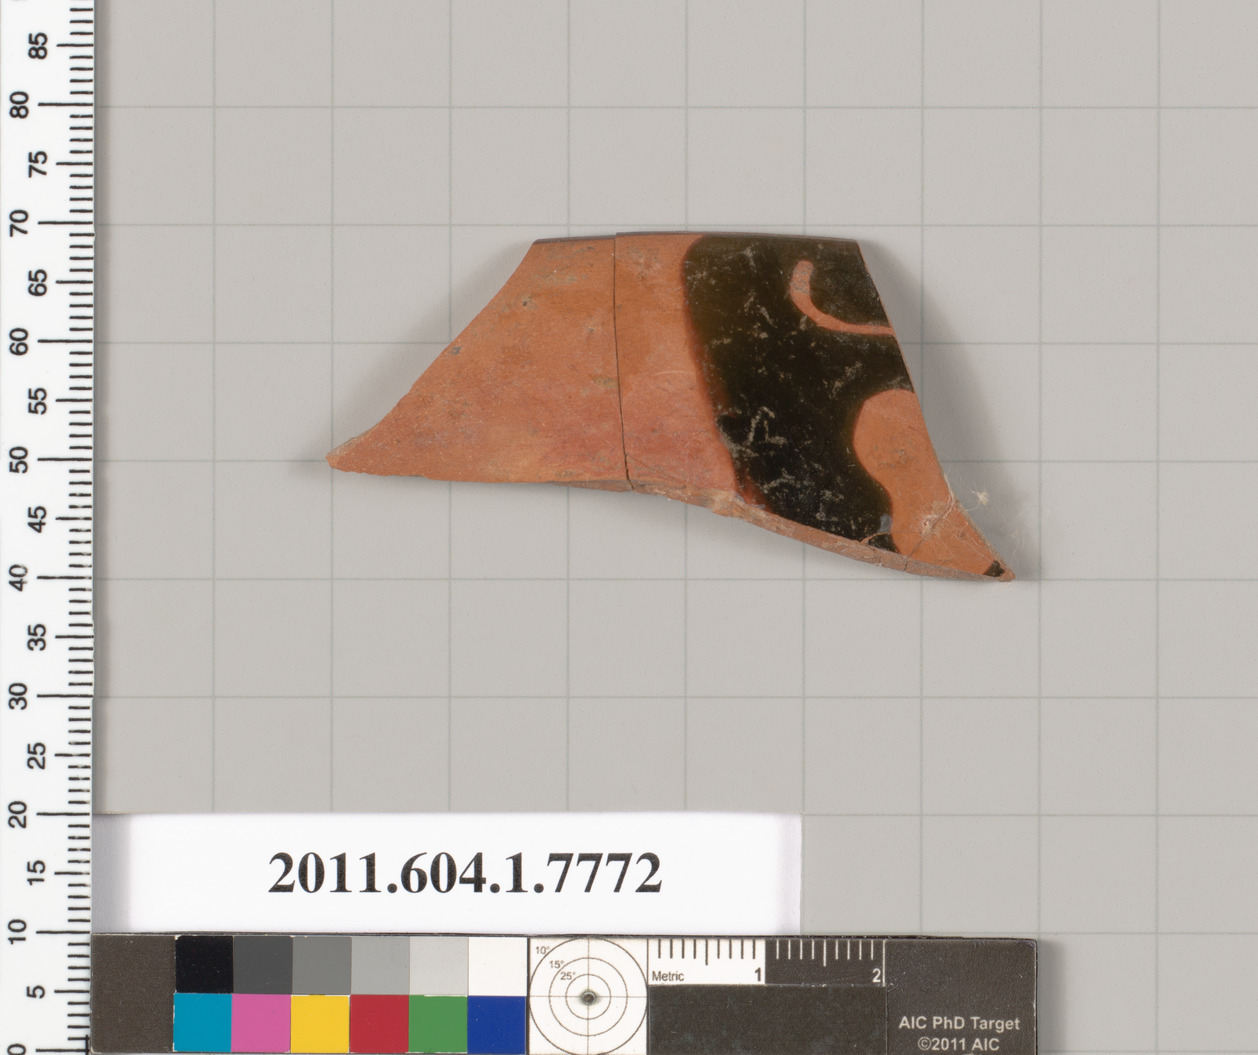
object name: kylix fragment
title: Terracotta rim fragment of a kylix (drinking cup)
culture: greek, attic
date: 460-450 BCE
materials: terracotta